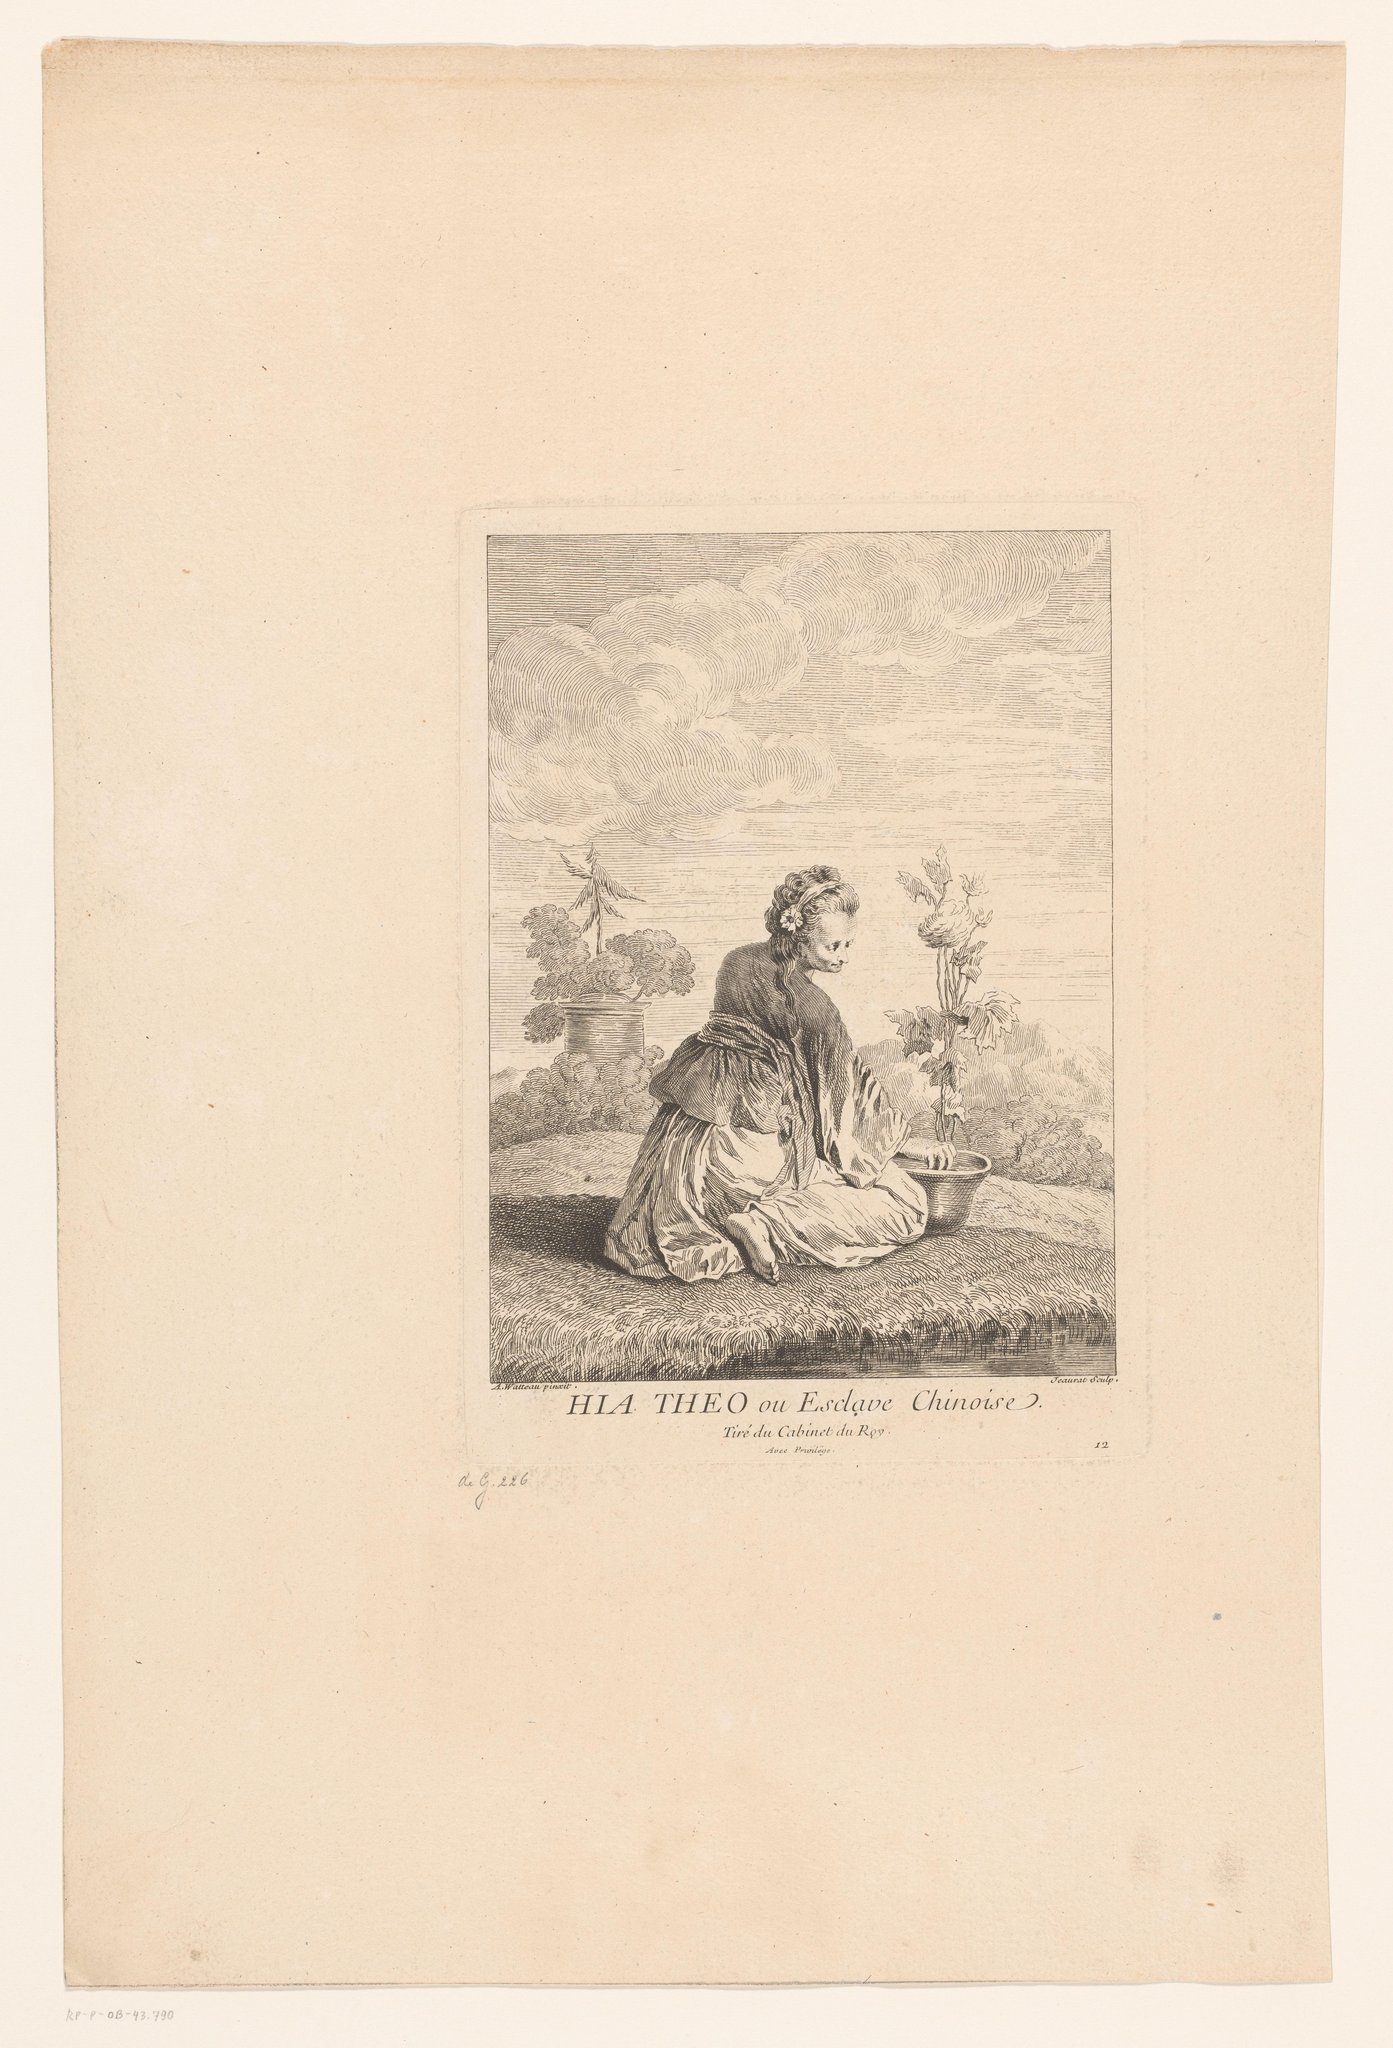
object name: print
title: Hia Theo ou Esclave Chinoise.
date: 1731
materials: paper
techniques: engraving, etching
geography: france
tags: chinese (+ costume), gardening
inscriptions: collector's mark: Lugt 2228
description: Plaat 260 uit 'L'Oeuvre d'Antoine Watteau', een serie van 271 platen, inclusief twee titelprenten, naar schilderijen door Watteau en verzameld door Jean de Jullienne. Maakt ook deel uit van een serie van 30 prenten over Chinese kostuums en van een subserie van 12 prenten gemaakt door Jeaurat.